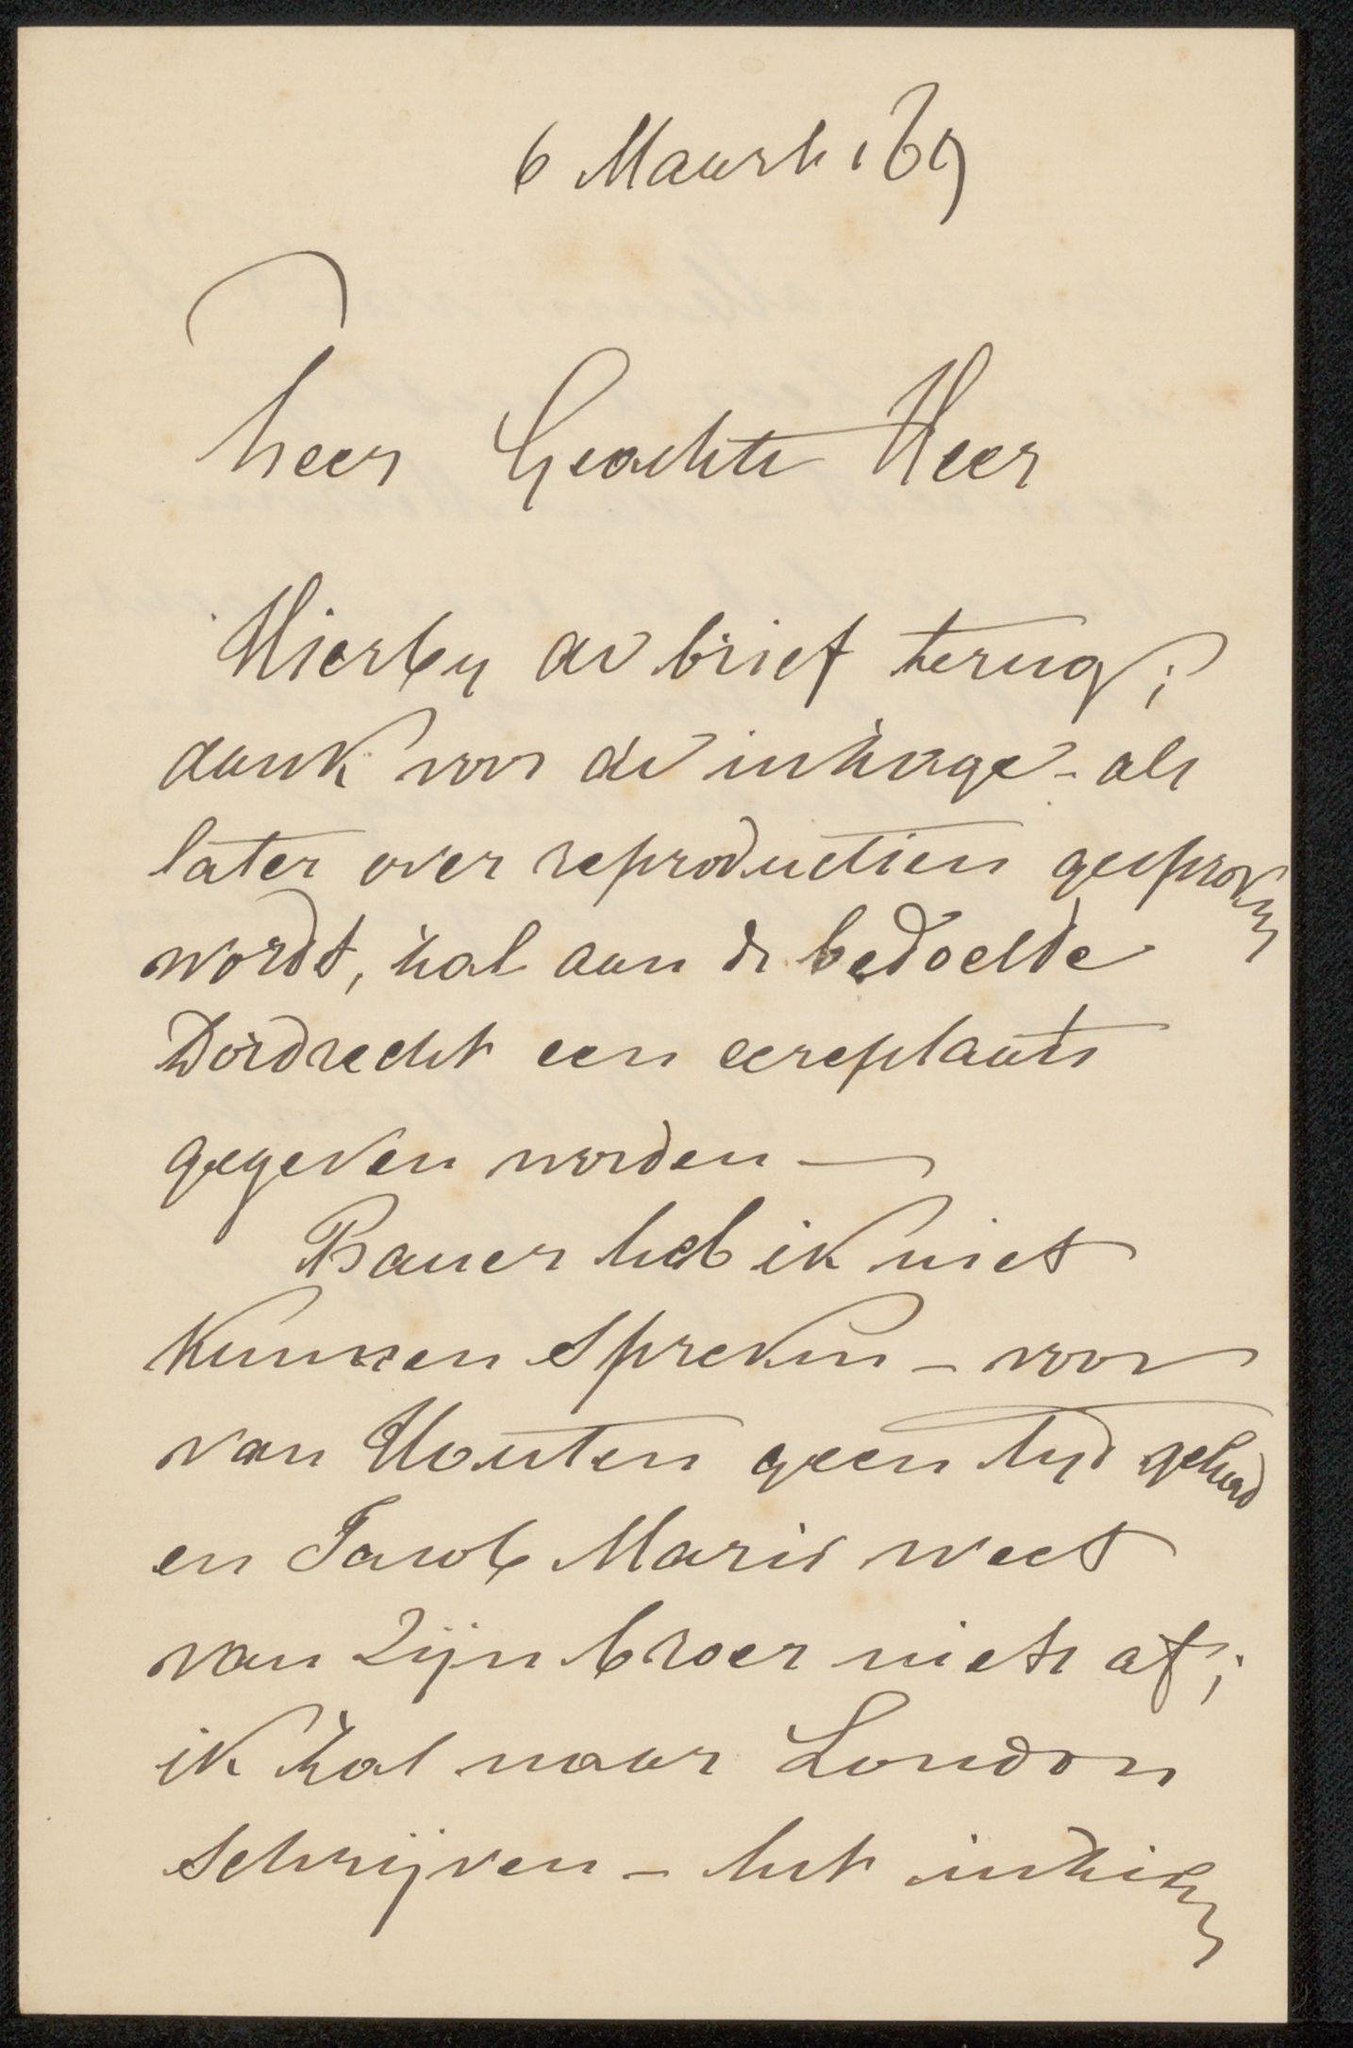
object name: letter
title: Brief aan Philip Zilcken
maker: edouard taurel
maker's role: draughtsman, print maker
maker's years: 1824-1892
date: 1889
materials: ink, paper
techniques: pen, writing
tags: painter, jacob maris, the hague, amsterdam, print maker, draughtsman, marius bauer, ariette sophia jeannette mauve-carbentus, philip zilcken, dordrecht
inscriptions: collector's mark: ‘RPK’, watermark